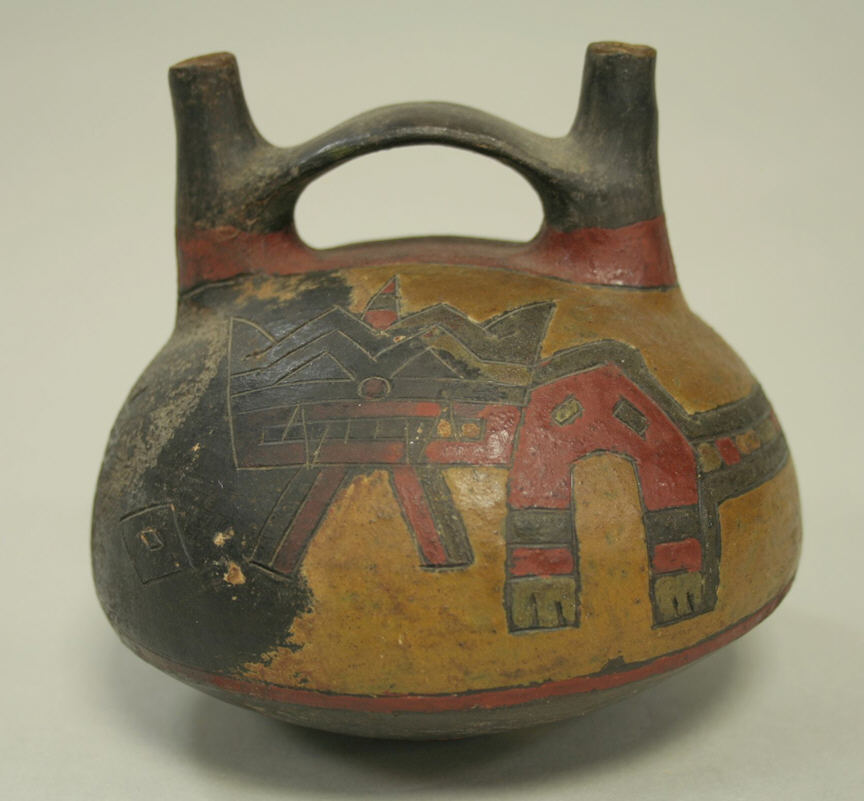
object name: bottle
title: Double Spout and Bridge Bottle with Incised Design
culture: paracas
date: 700-401 BCE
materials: ceramic, pigment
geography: peru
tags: animals